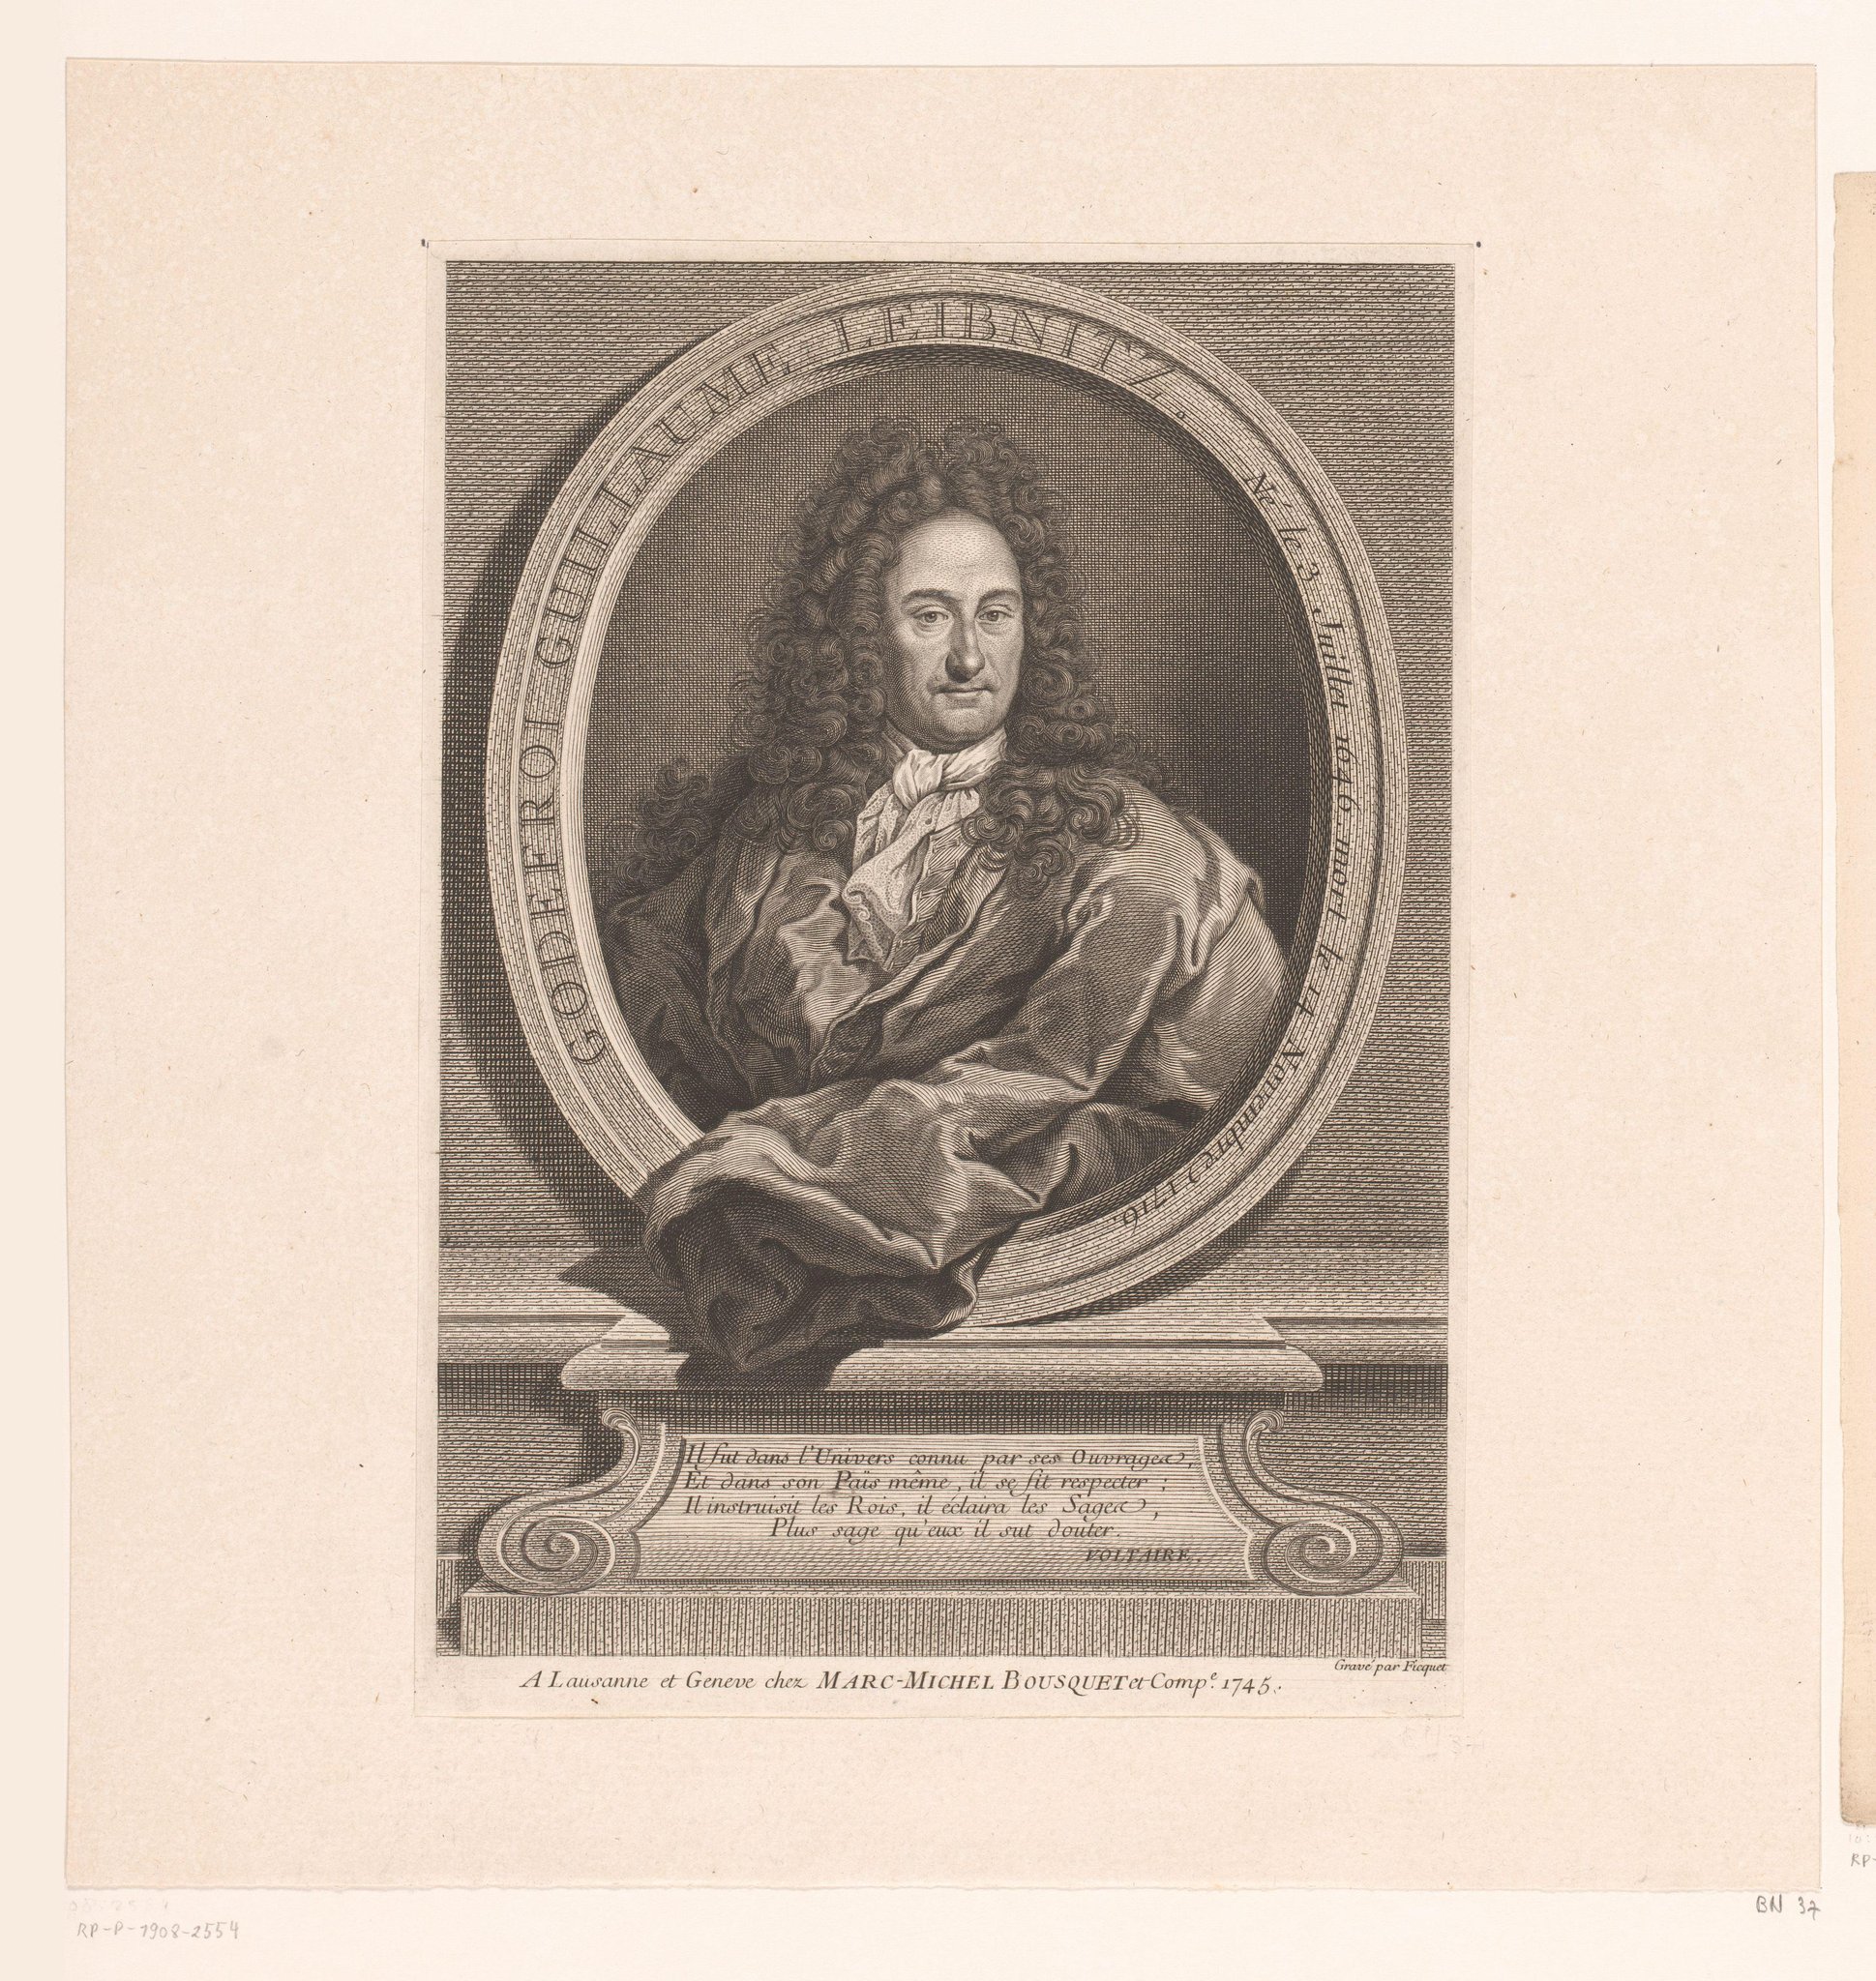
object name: print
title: Godefroi Guillaume Leibnitz.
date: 1745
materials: paper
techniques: engraving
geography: lausanne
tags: scholar, philosopher, ornament ~ medallion, historical persons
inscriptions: collector's mark: Lugt 2228